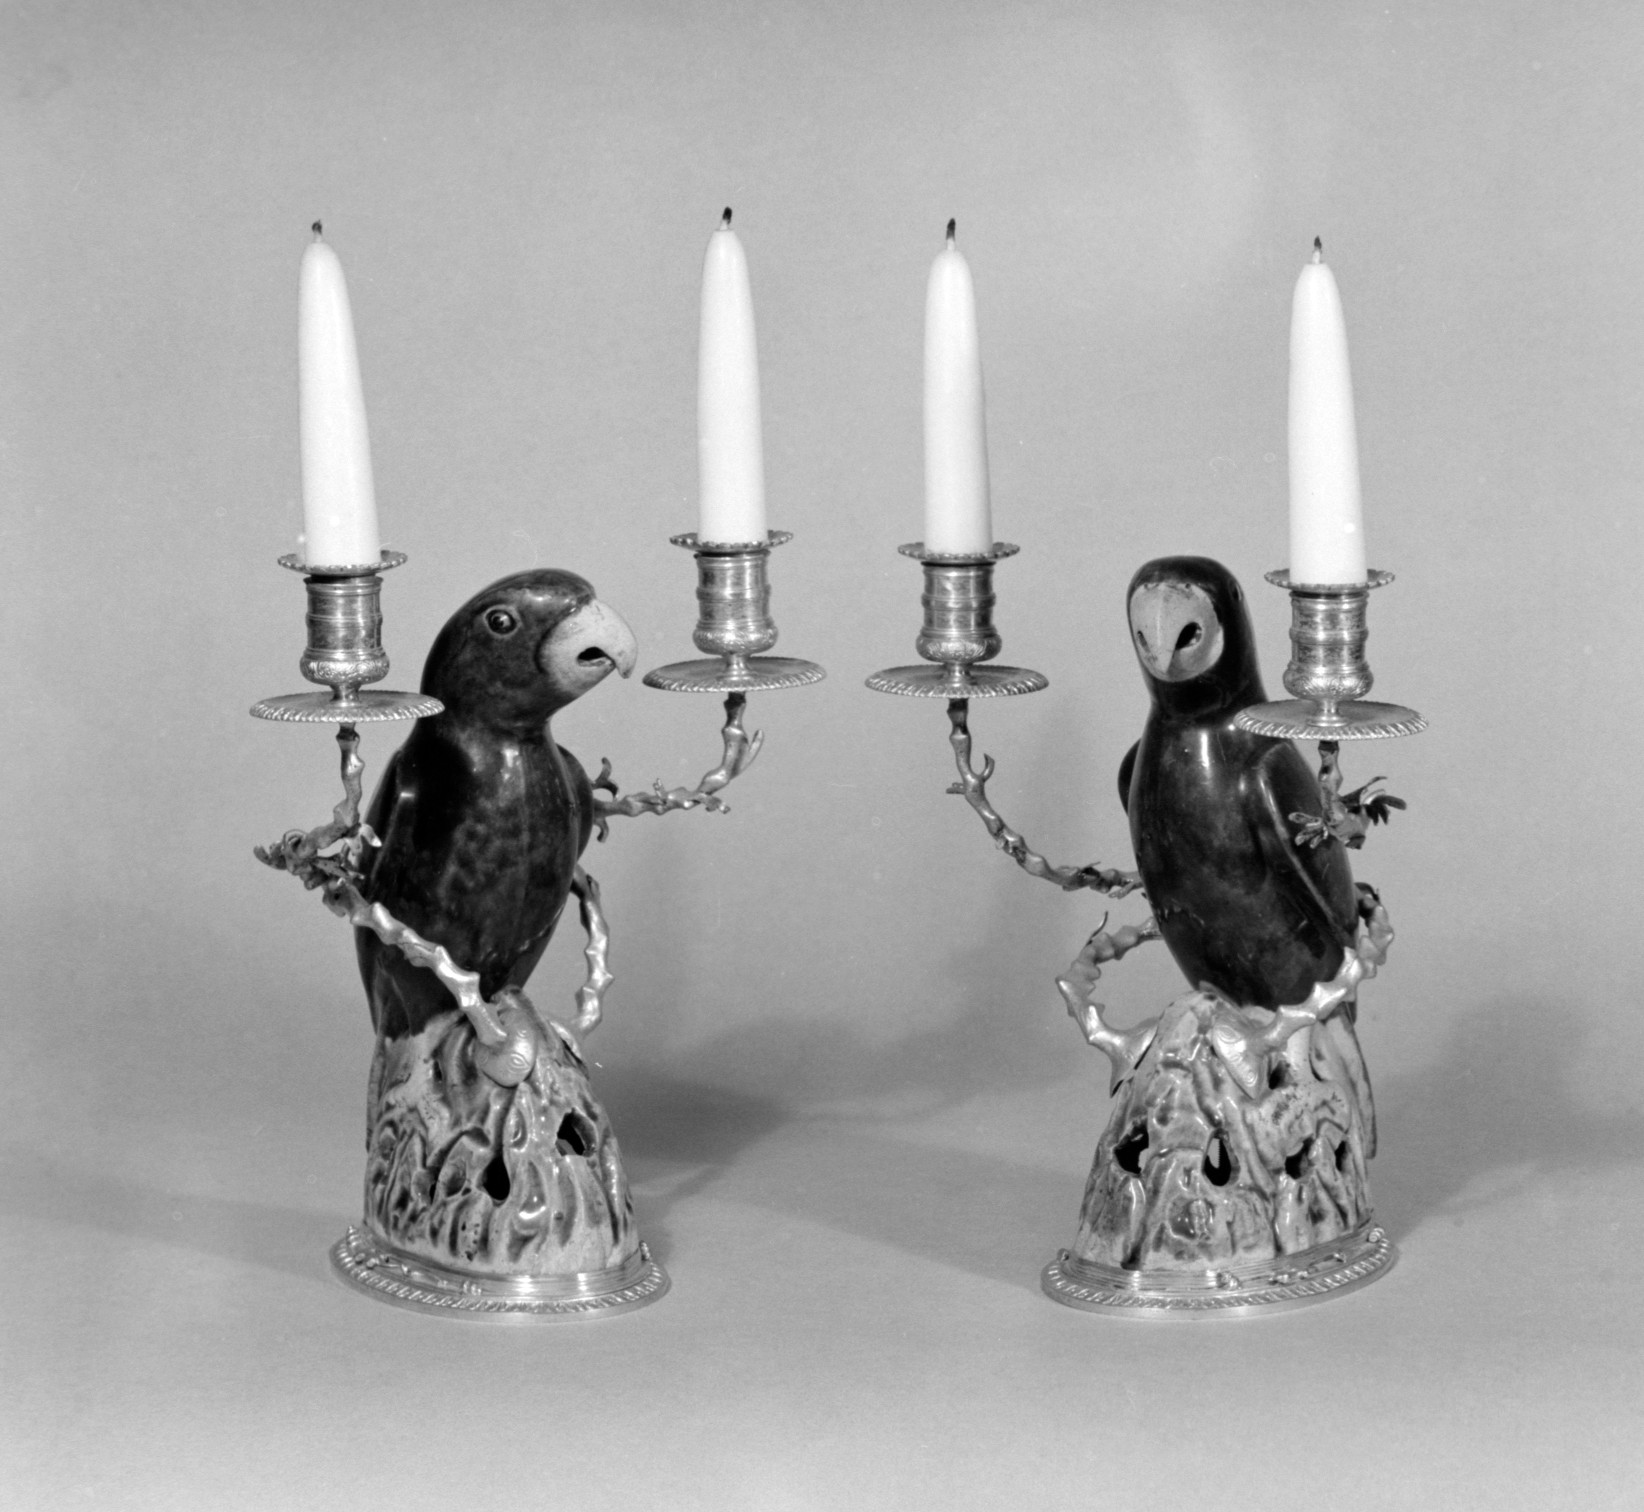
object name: candelabrum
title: Pair of parrots mounted as two-branch candelabra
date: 1785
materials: gilt bronze, porcelain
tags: parrots